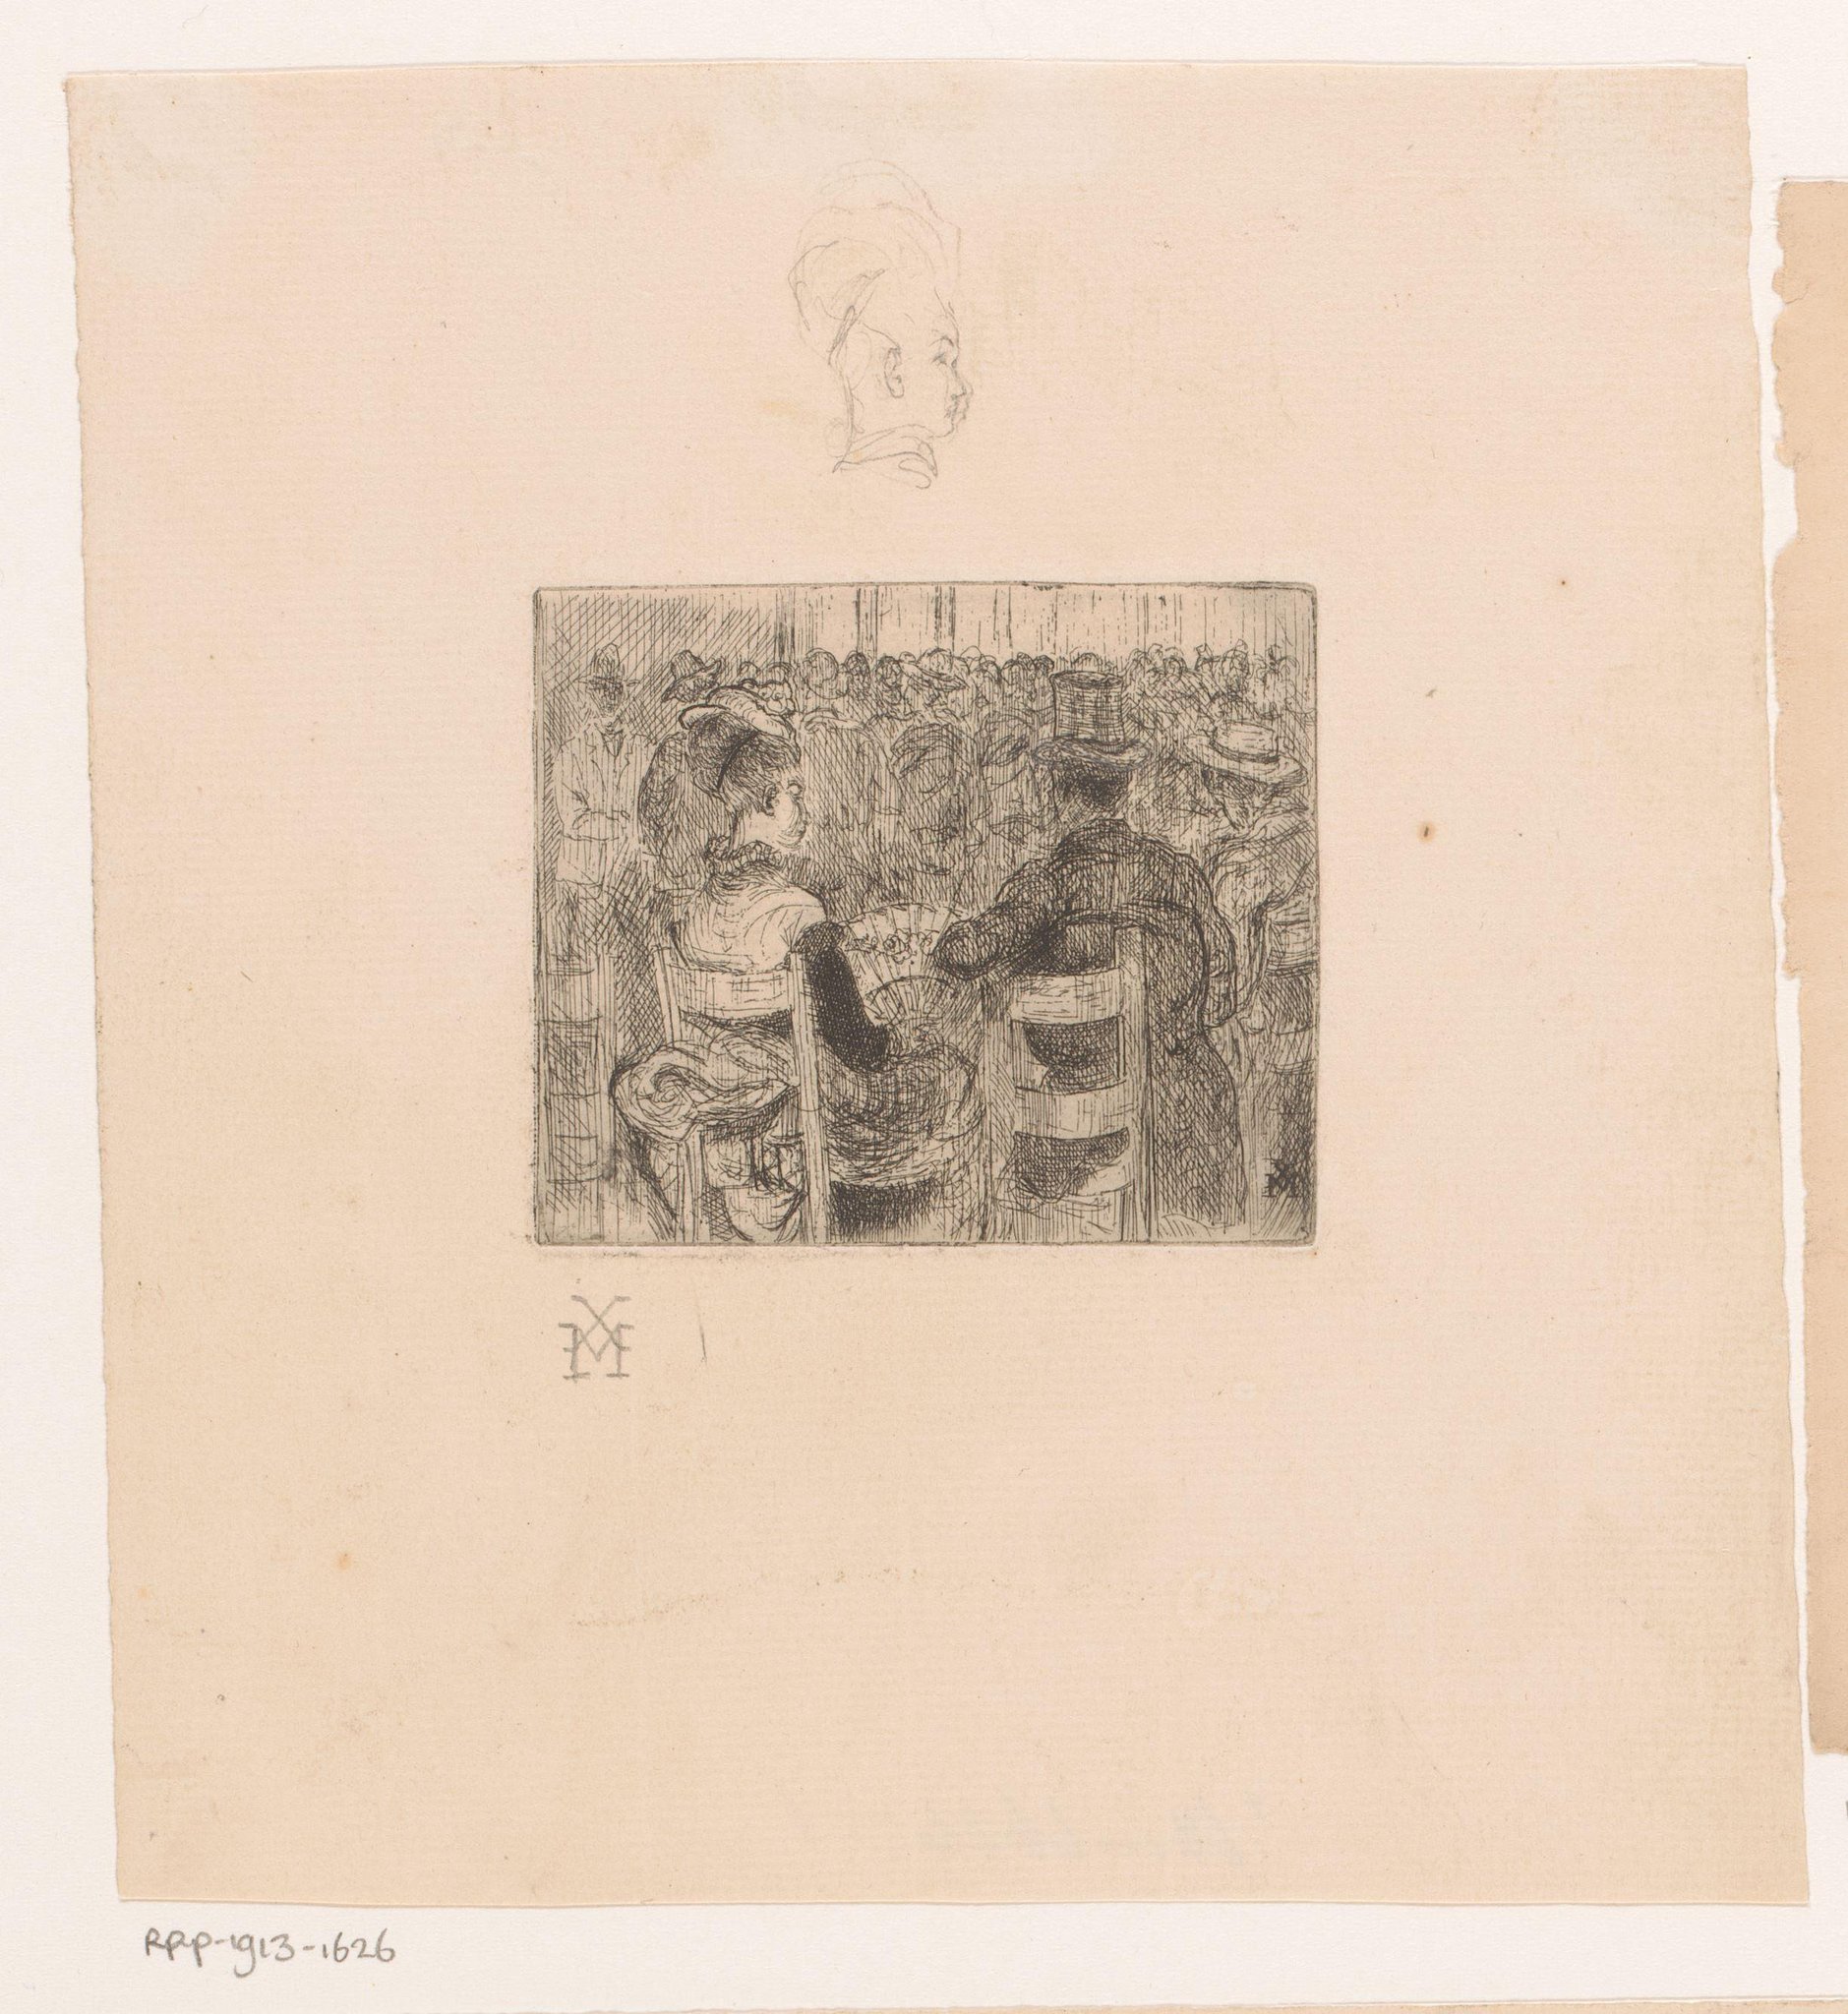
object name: print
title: Vrouw met waaier en man met hoed op een stoel in een menigte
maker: xavier mellery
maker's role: print maker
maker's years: 1845-1921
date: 1855-1913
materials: paper, pencil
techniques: etching, intaglio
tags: crowd, mob, sitting figure, fan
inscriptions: collector's mark: Lugt 2228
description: Boven de voorstelling een schets van het hoofd van de vrouw met waaier.